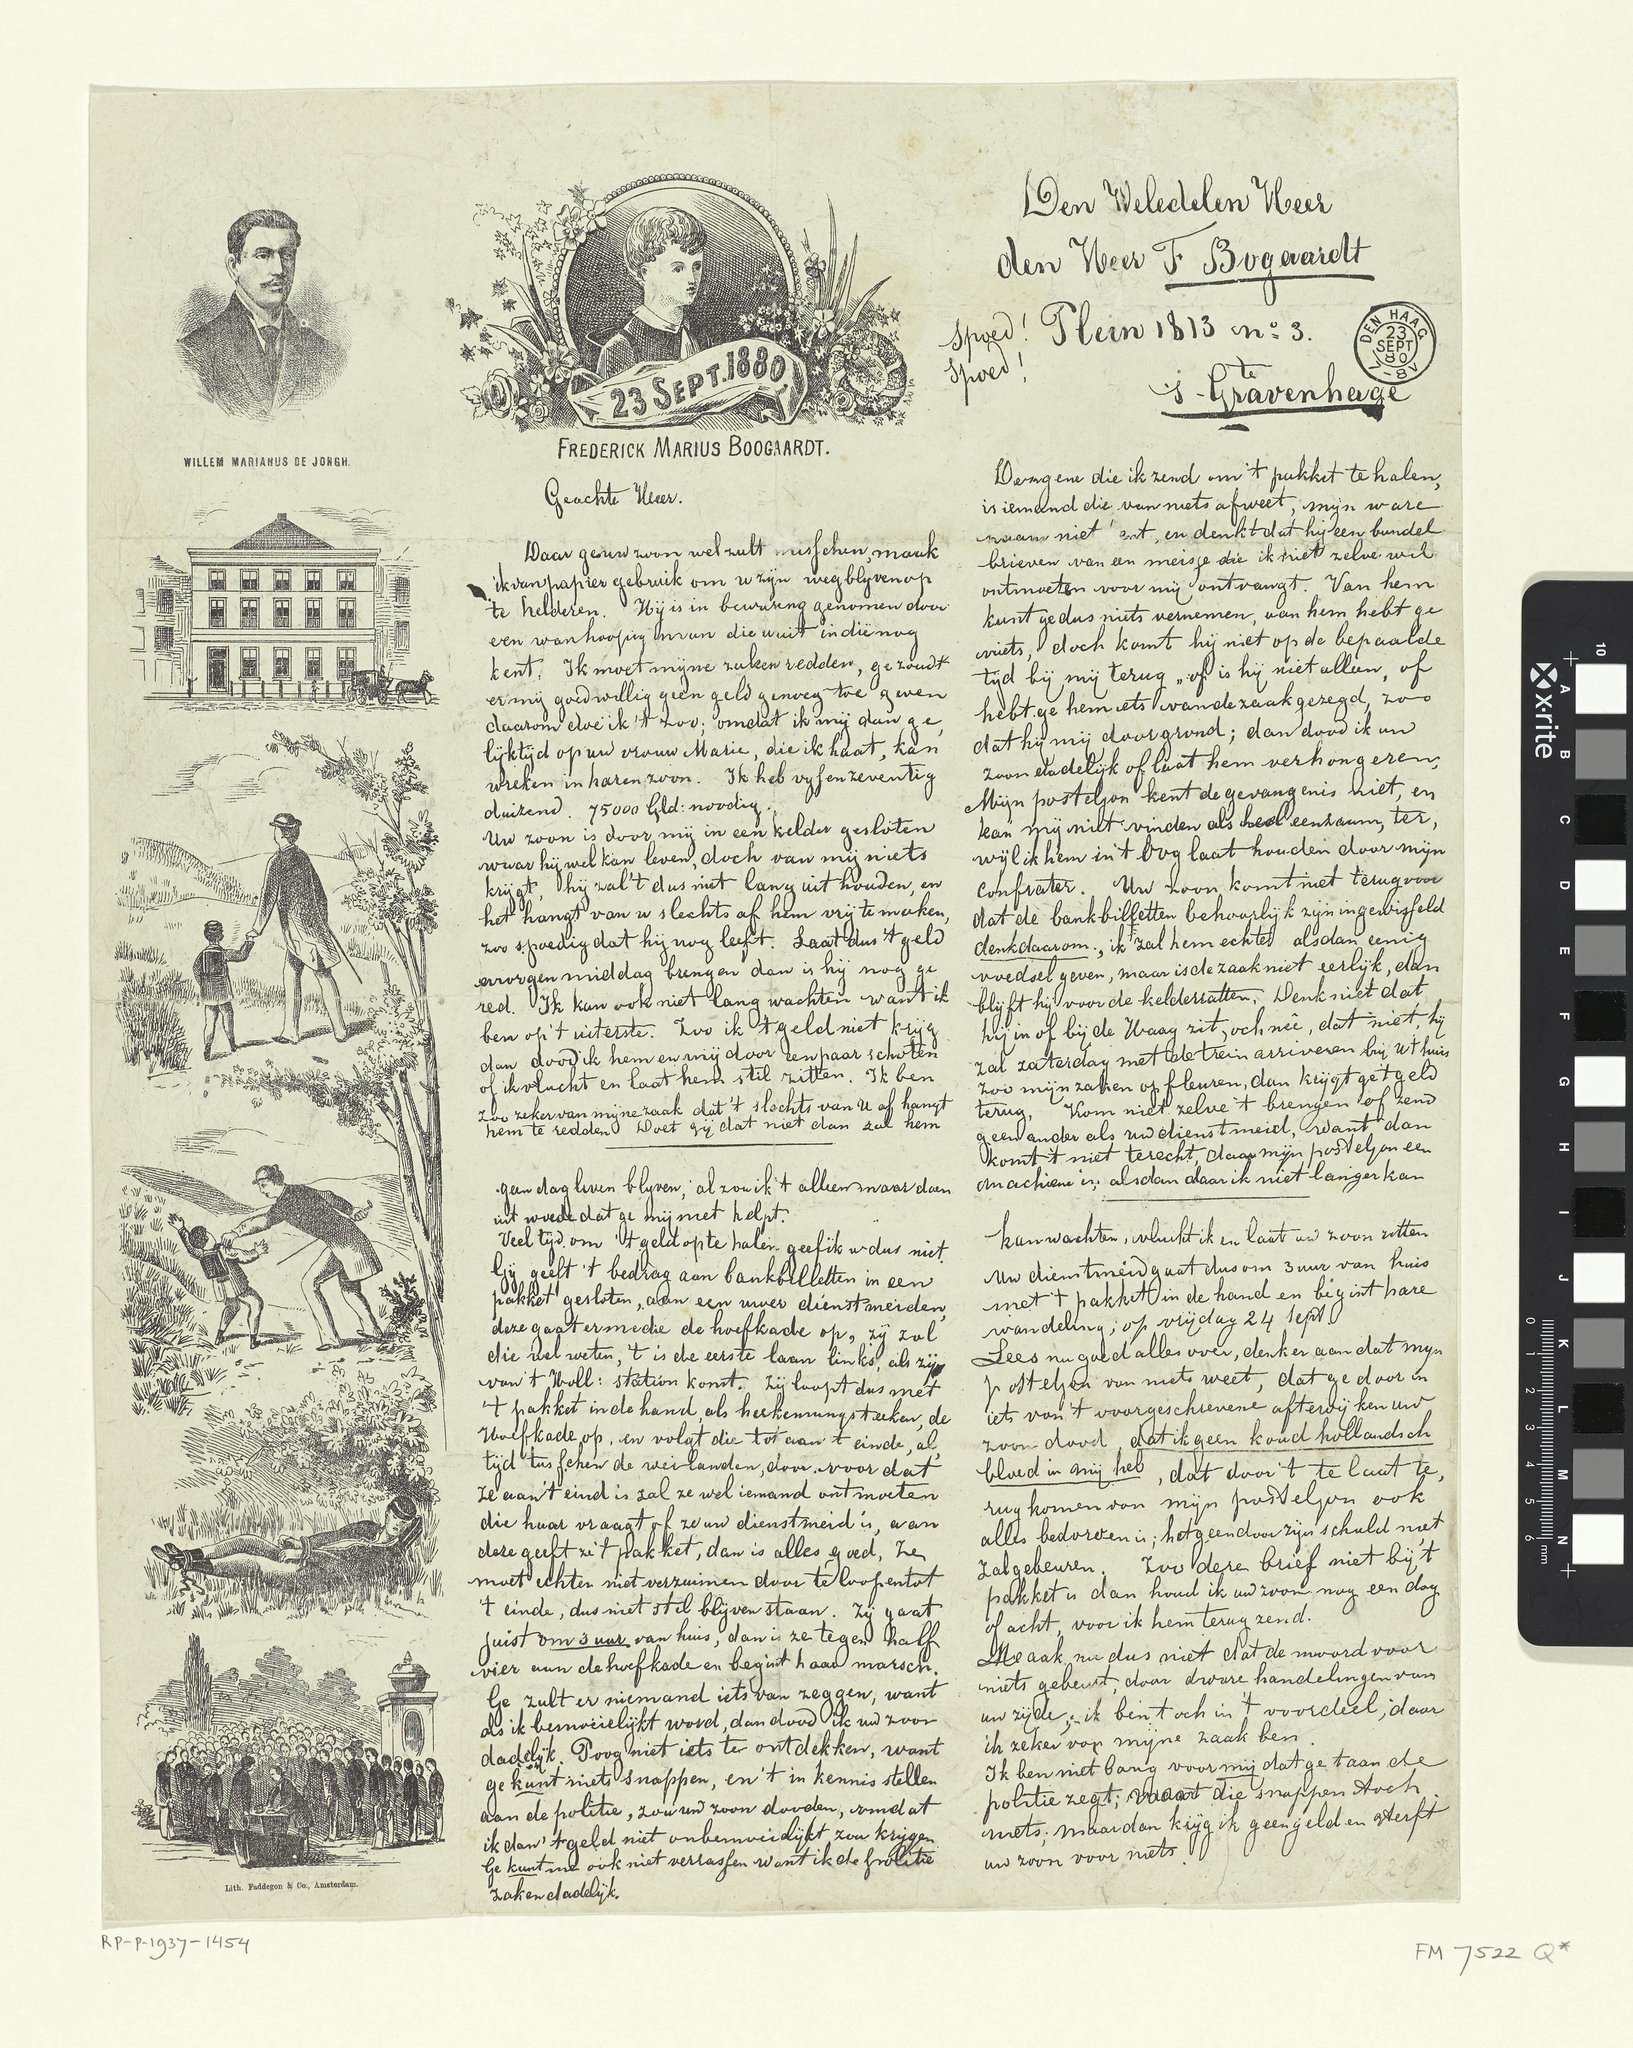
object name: print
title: Moord op de jongen Frederick Boogaardt, 23 september 1880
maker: Anonymous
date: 1880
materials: paper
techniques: lithograph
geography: amsterdam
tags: murder, funerary ceremonial, kidnapping, the hague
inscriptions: collector's mark: Lugt 2228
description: Blad over de ontvoering en moord op de jongen Frederick Marius Boogaardt, 23 september 1880. Rechts de brief gericht aan de vader met tekst in twee kolommen waarin de ontvoerder om losgeld vraagt. Links en boven randillustraties van de ontvoering, moord, begrafenis en portretten van de jongen en van de moordenaar Willem Marianus de Jongh.